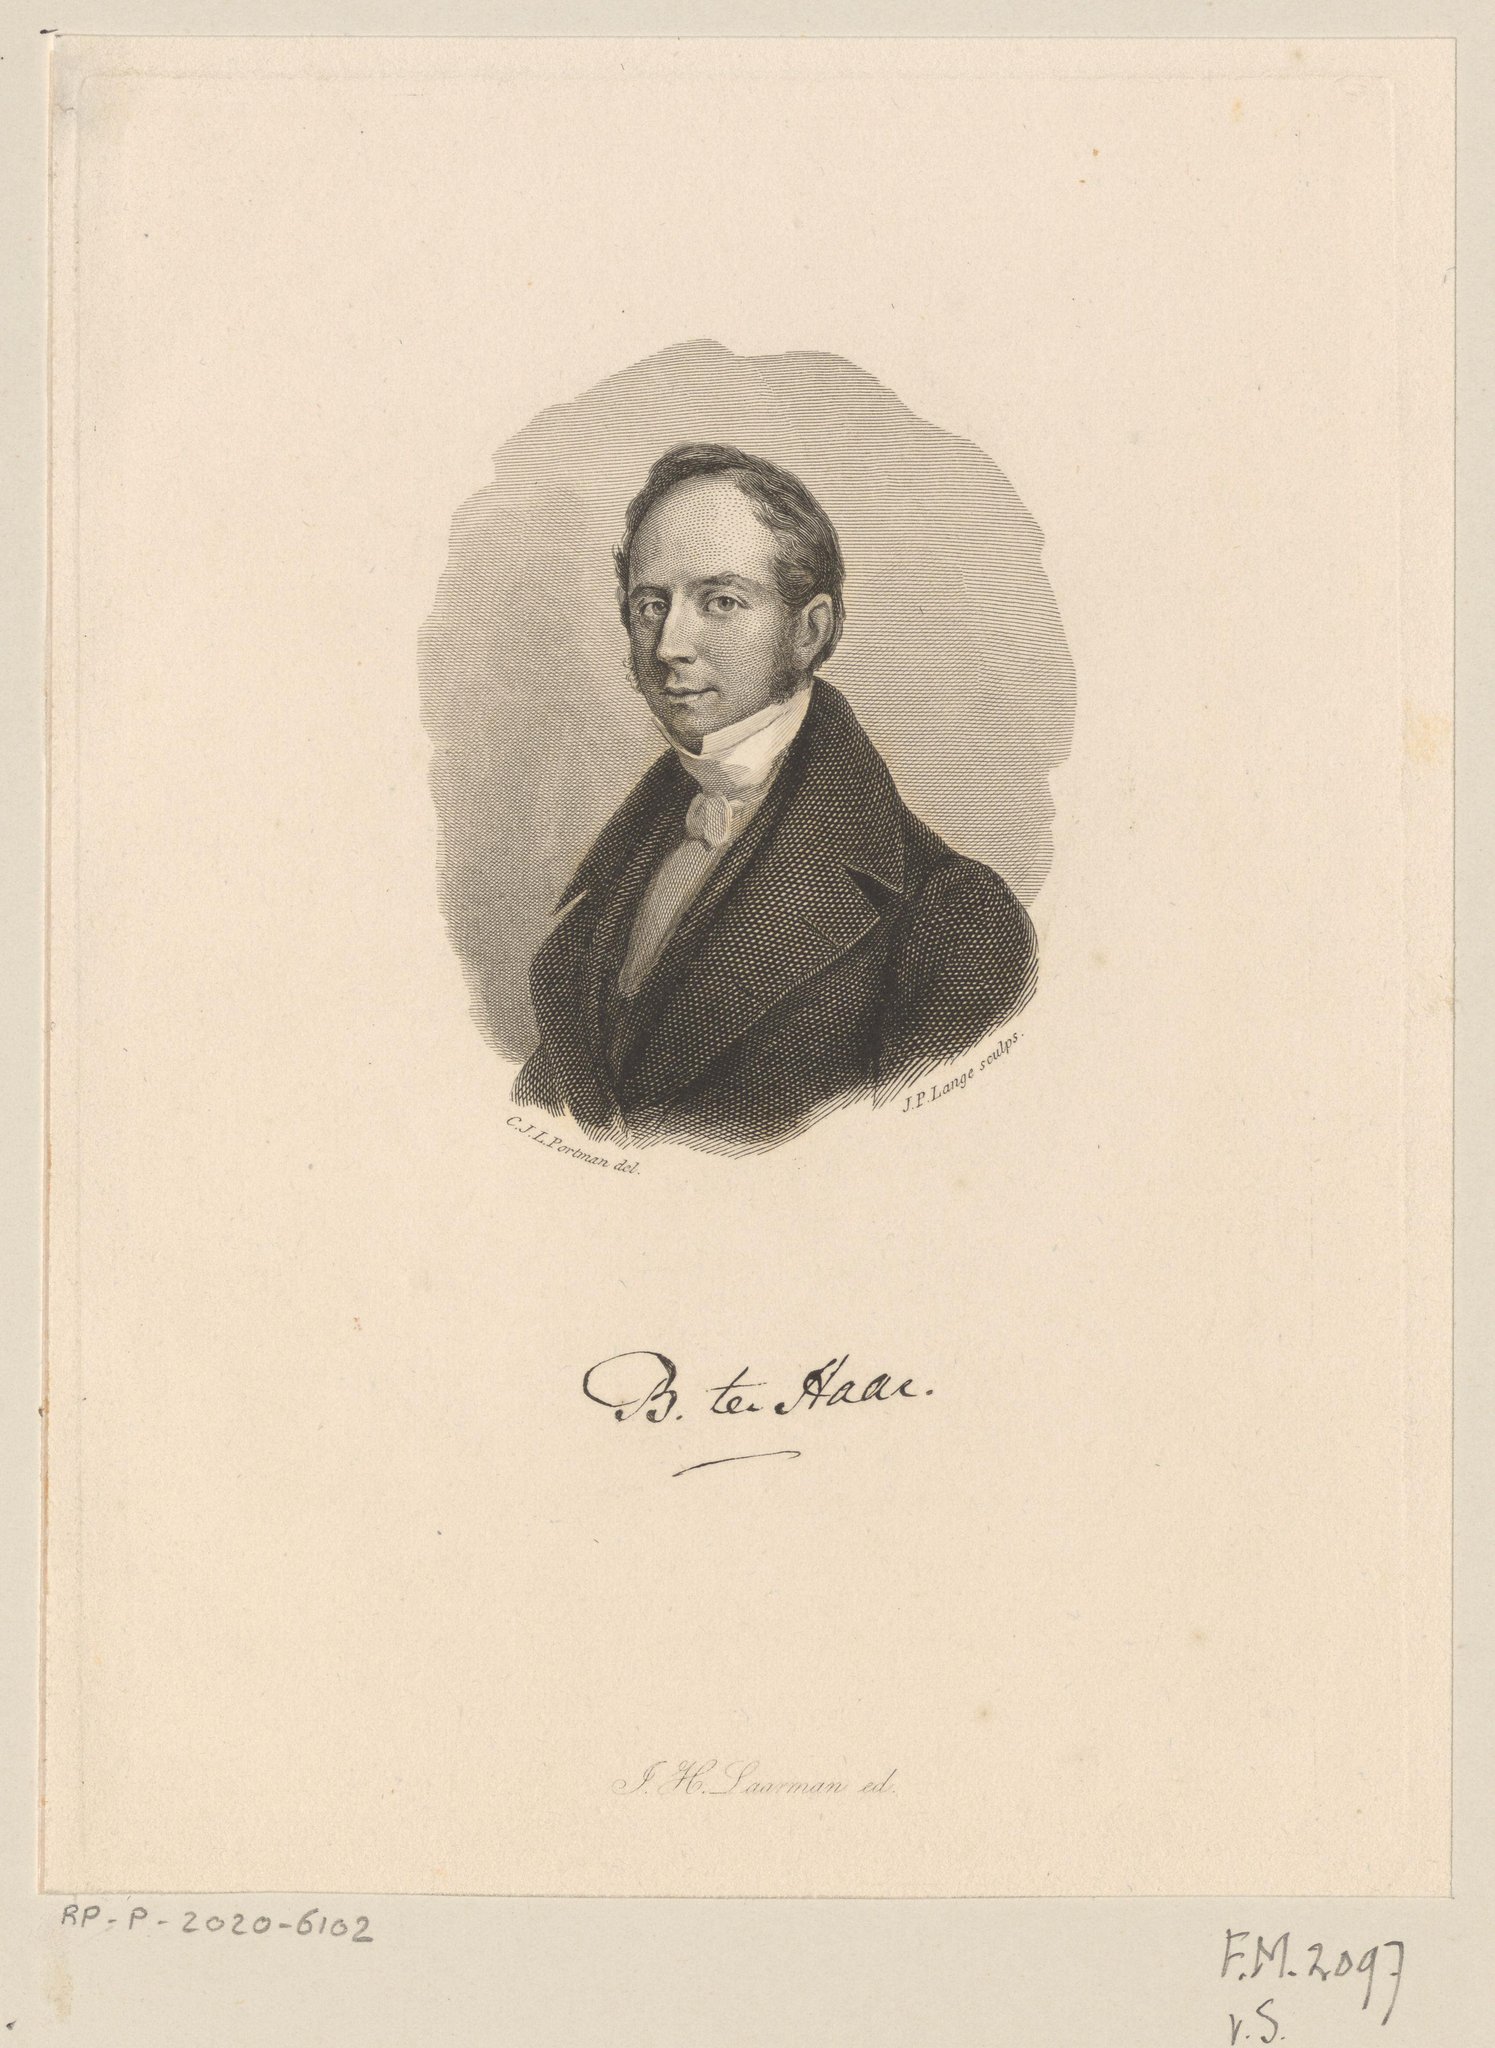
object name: print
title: Portret van Bernard ter Haar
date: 1830-1849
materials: paper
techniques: engraving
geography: amsterdam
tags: amsterdam, bernard ter haar, historical persons